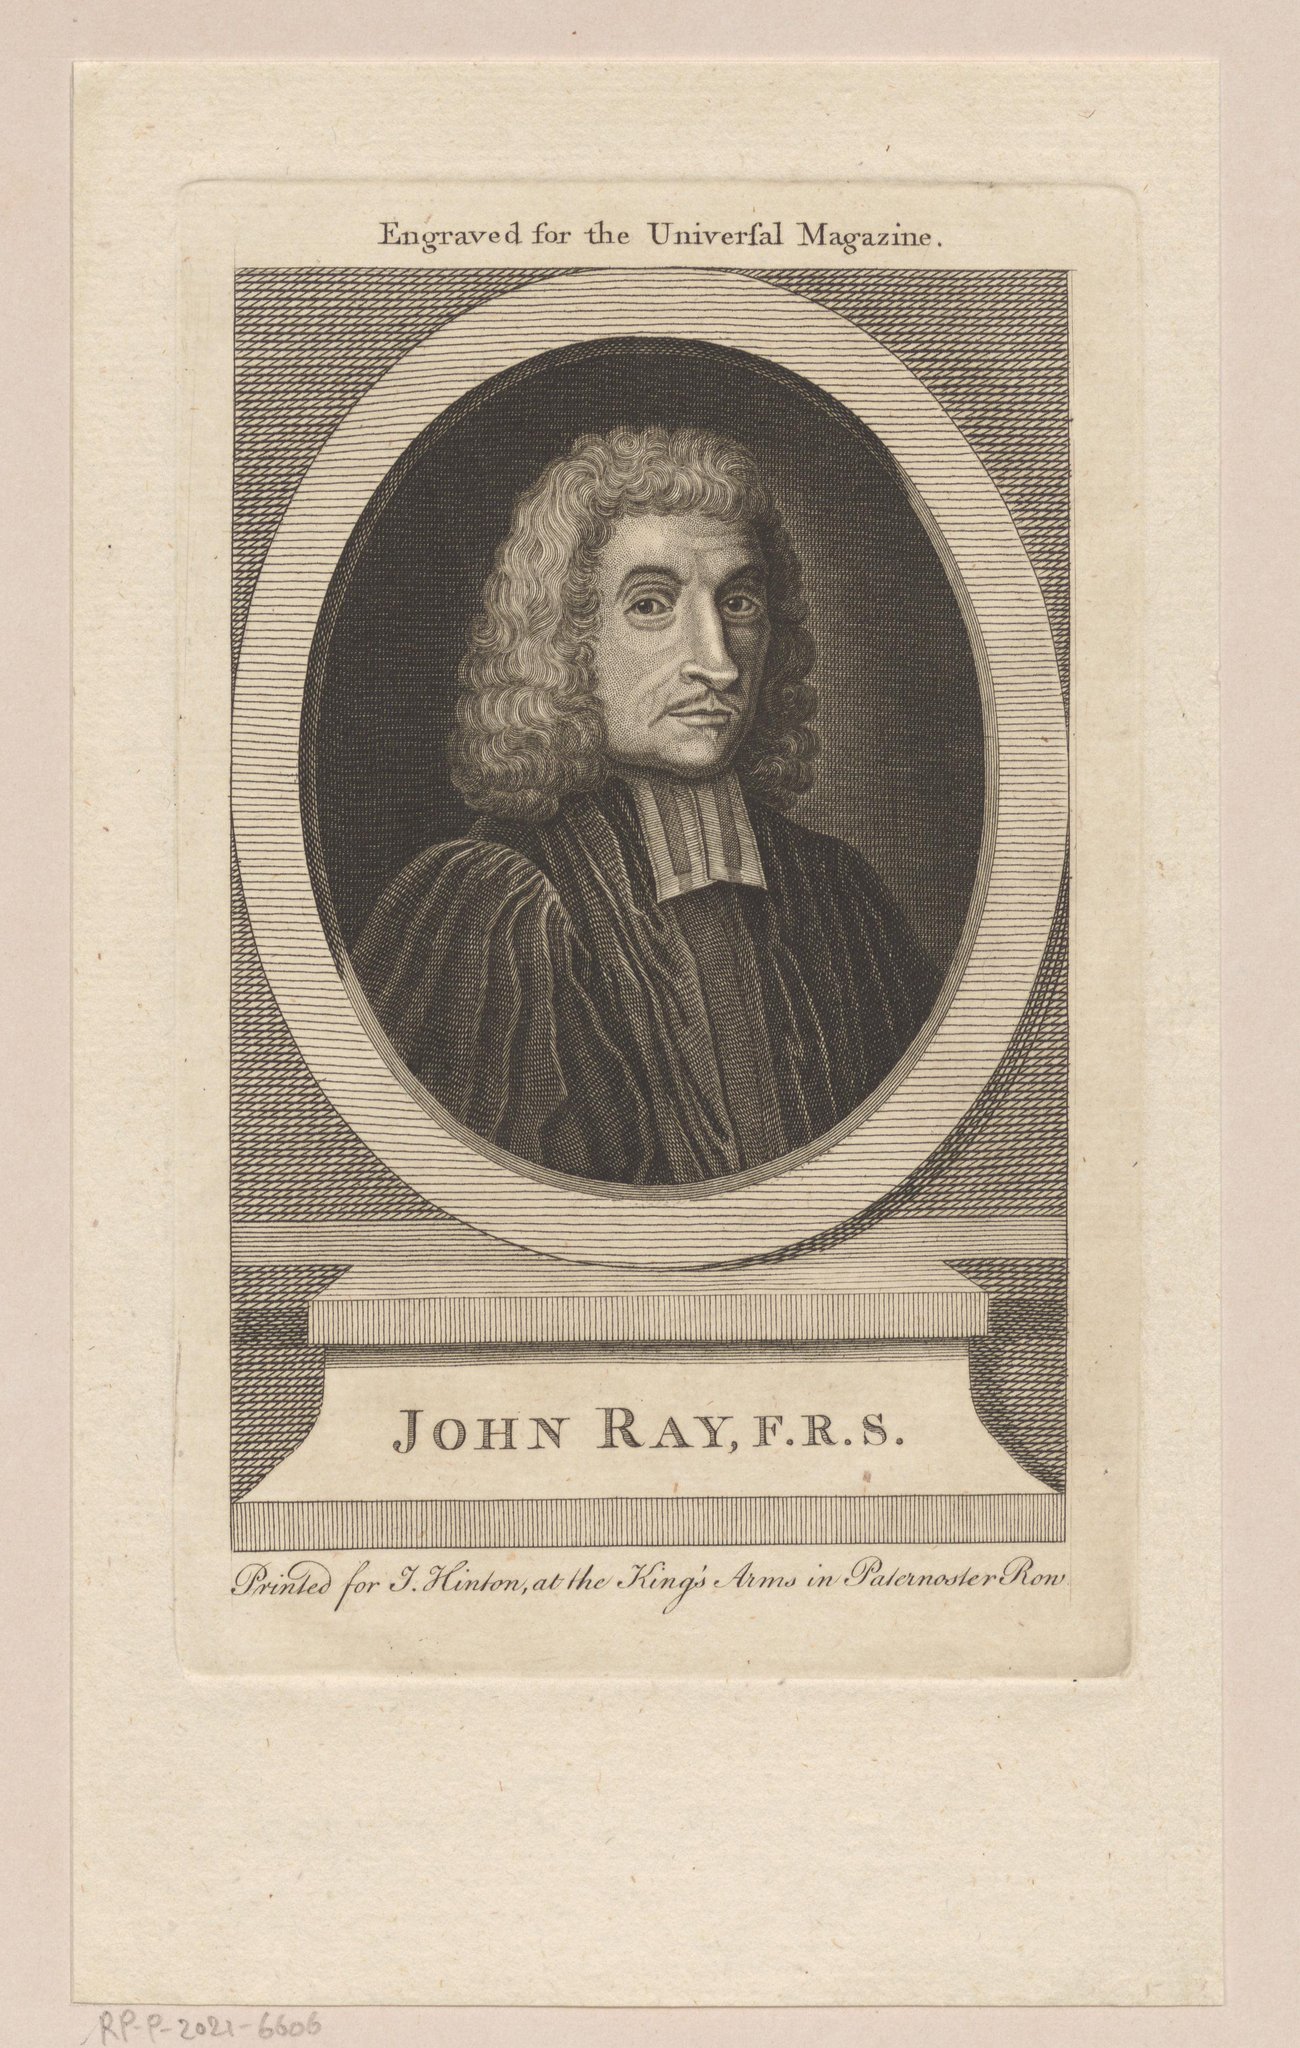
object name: print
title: Portret van Joannes de Ray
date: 1747-1781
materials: paper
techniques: engraving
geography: london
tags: historical persons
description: Prent uit: Universal Magazine, uitgegeven tussen 1747-1814.